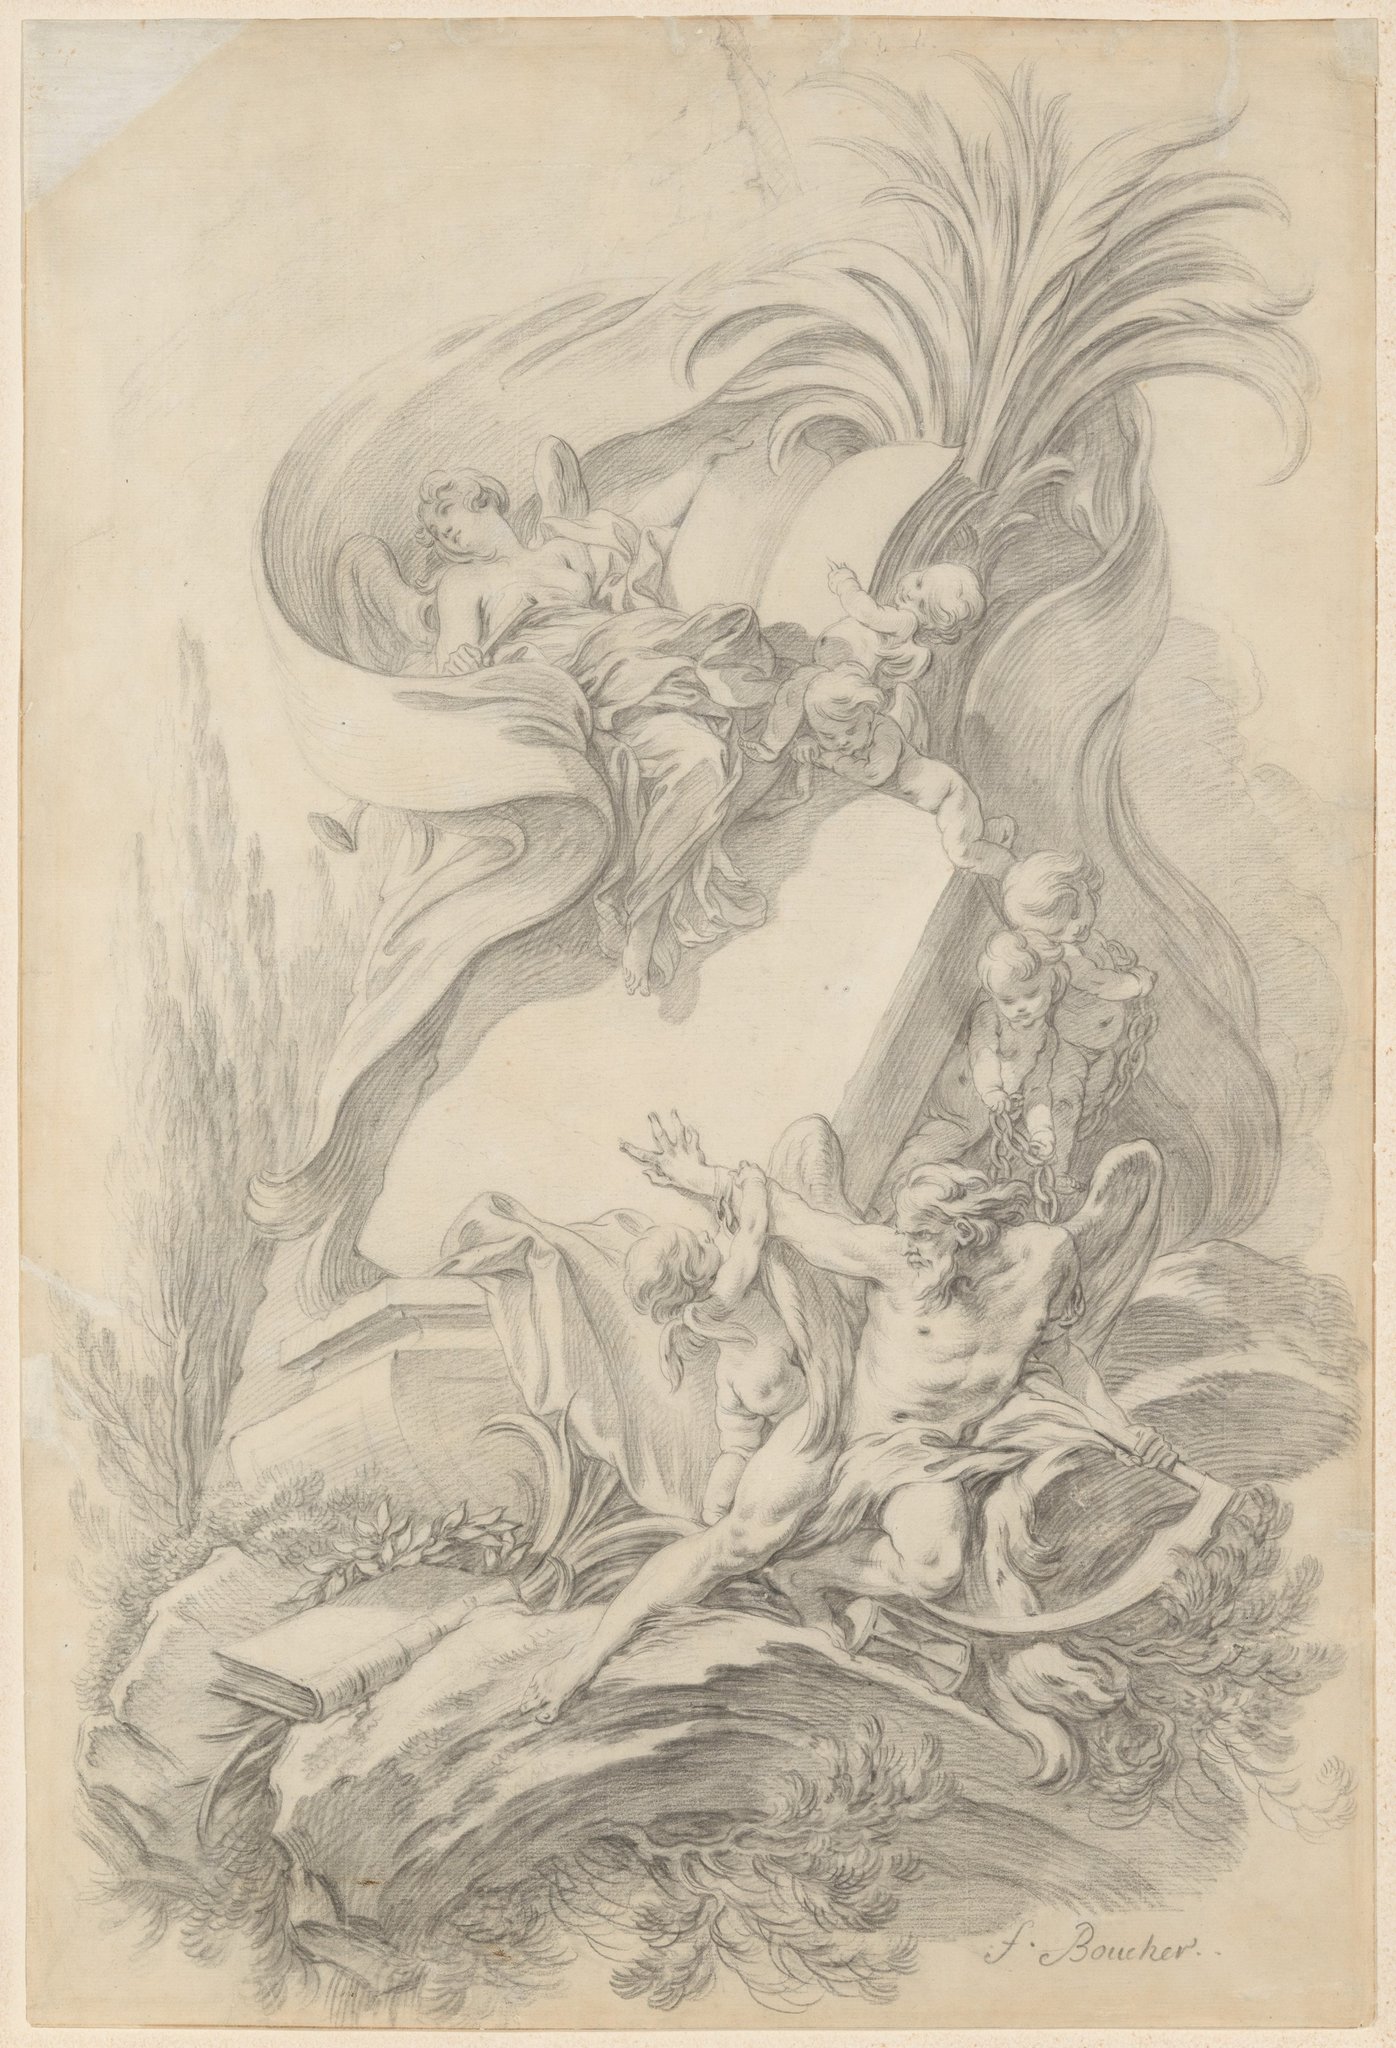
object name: drawing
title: Design for a Frontispiece: Love Staying the Hand of Time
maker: françois boucher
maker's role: artist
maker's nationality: french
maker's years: 1703-1770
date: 1700-1770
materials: chalk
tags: books,men,leaves